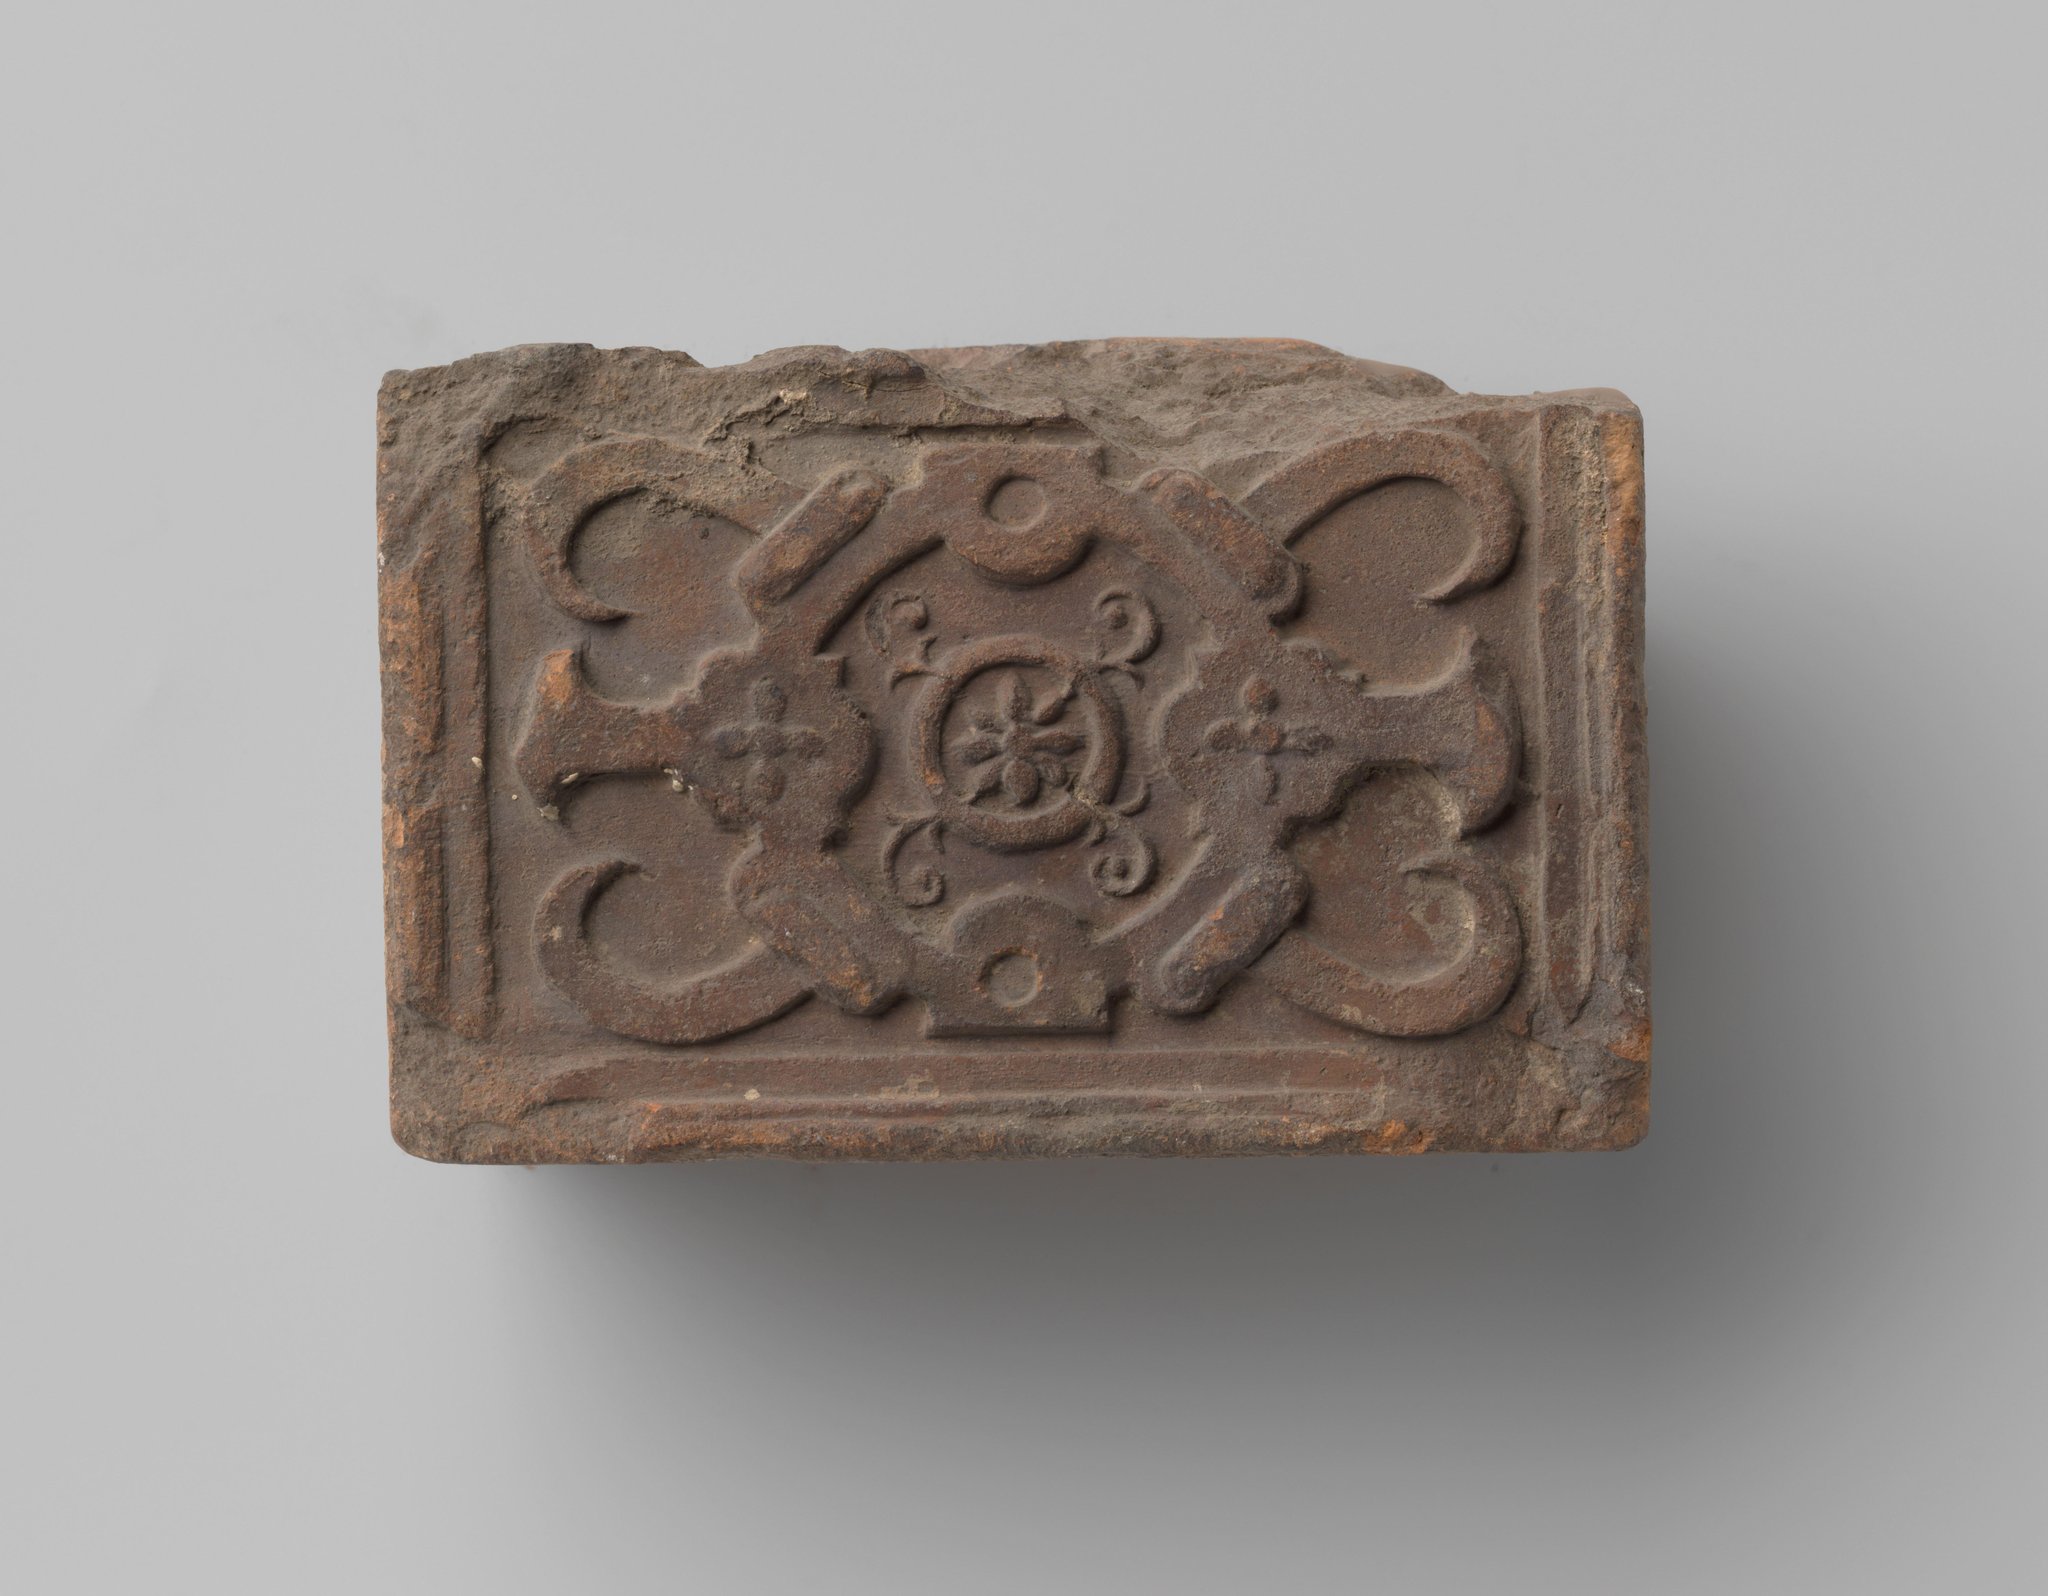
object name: hearthstone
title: Haardsteen met cartouche van rolwerk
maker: Anonymous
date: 1575-1600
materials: earthenware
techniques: printing, firing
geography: southern netherlands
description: Haardsteen met cartouche van rolwerk. Bovenzijde afgebrokkeld.